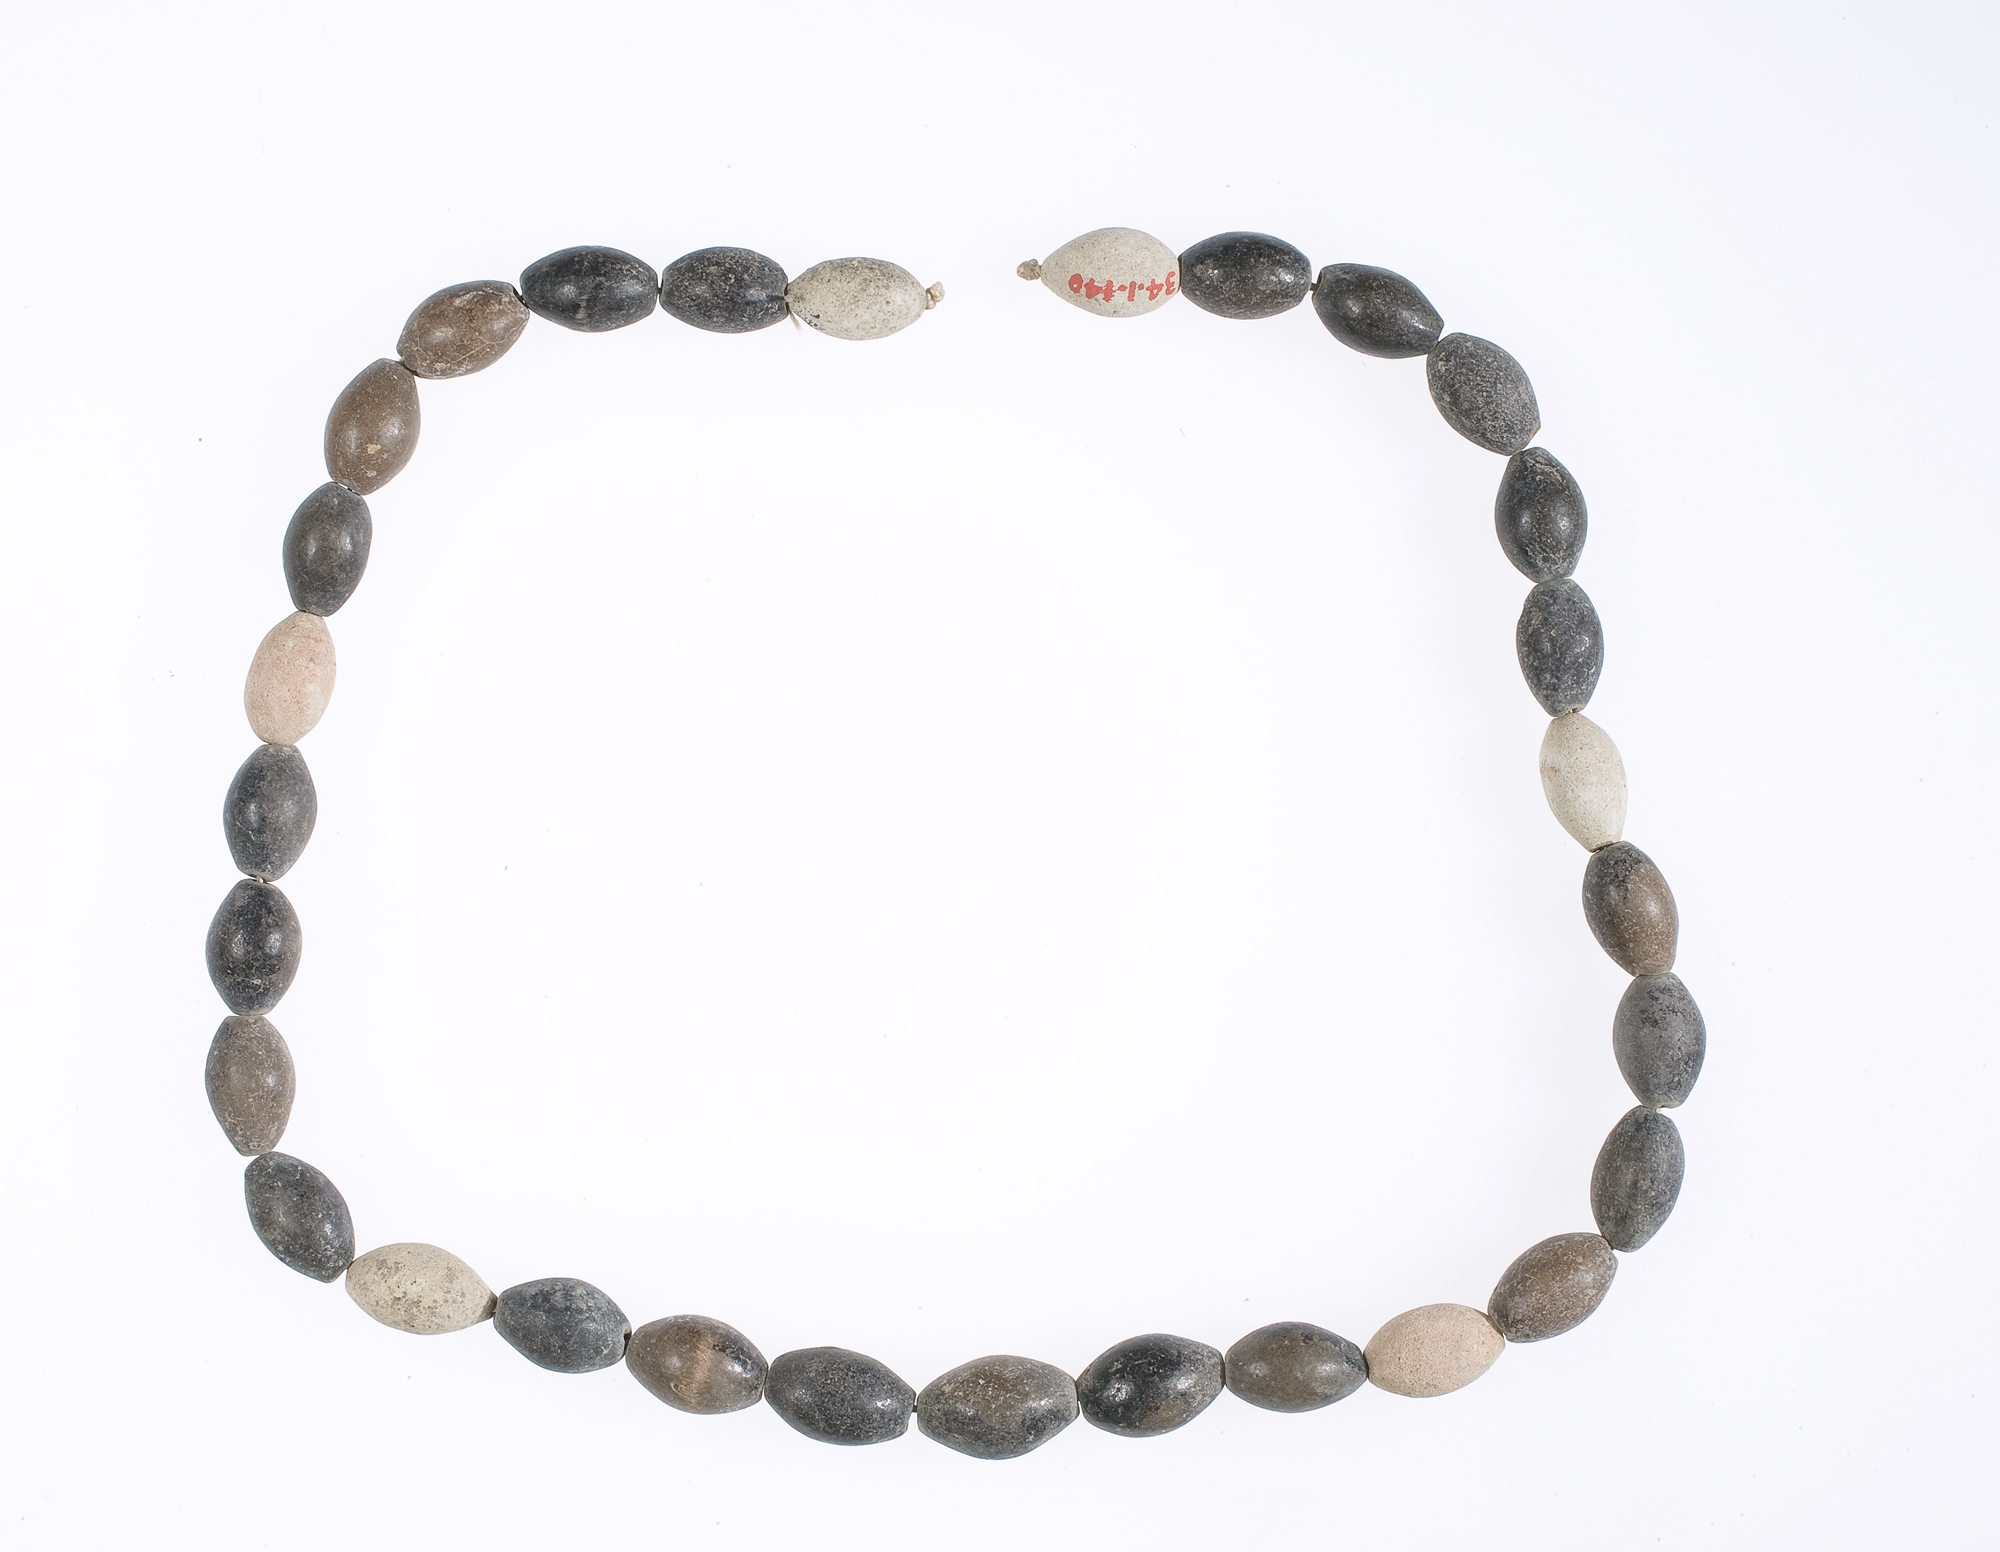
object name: bead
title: Hepy, beads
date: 1950-1885 BCE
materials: faience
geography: egypt